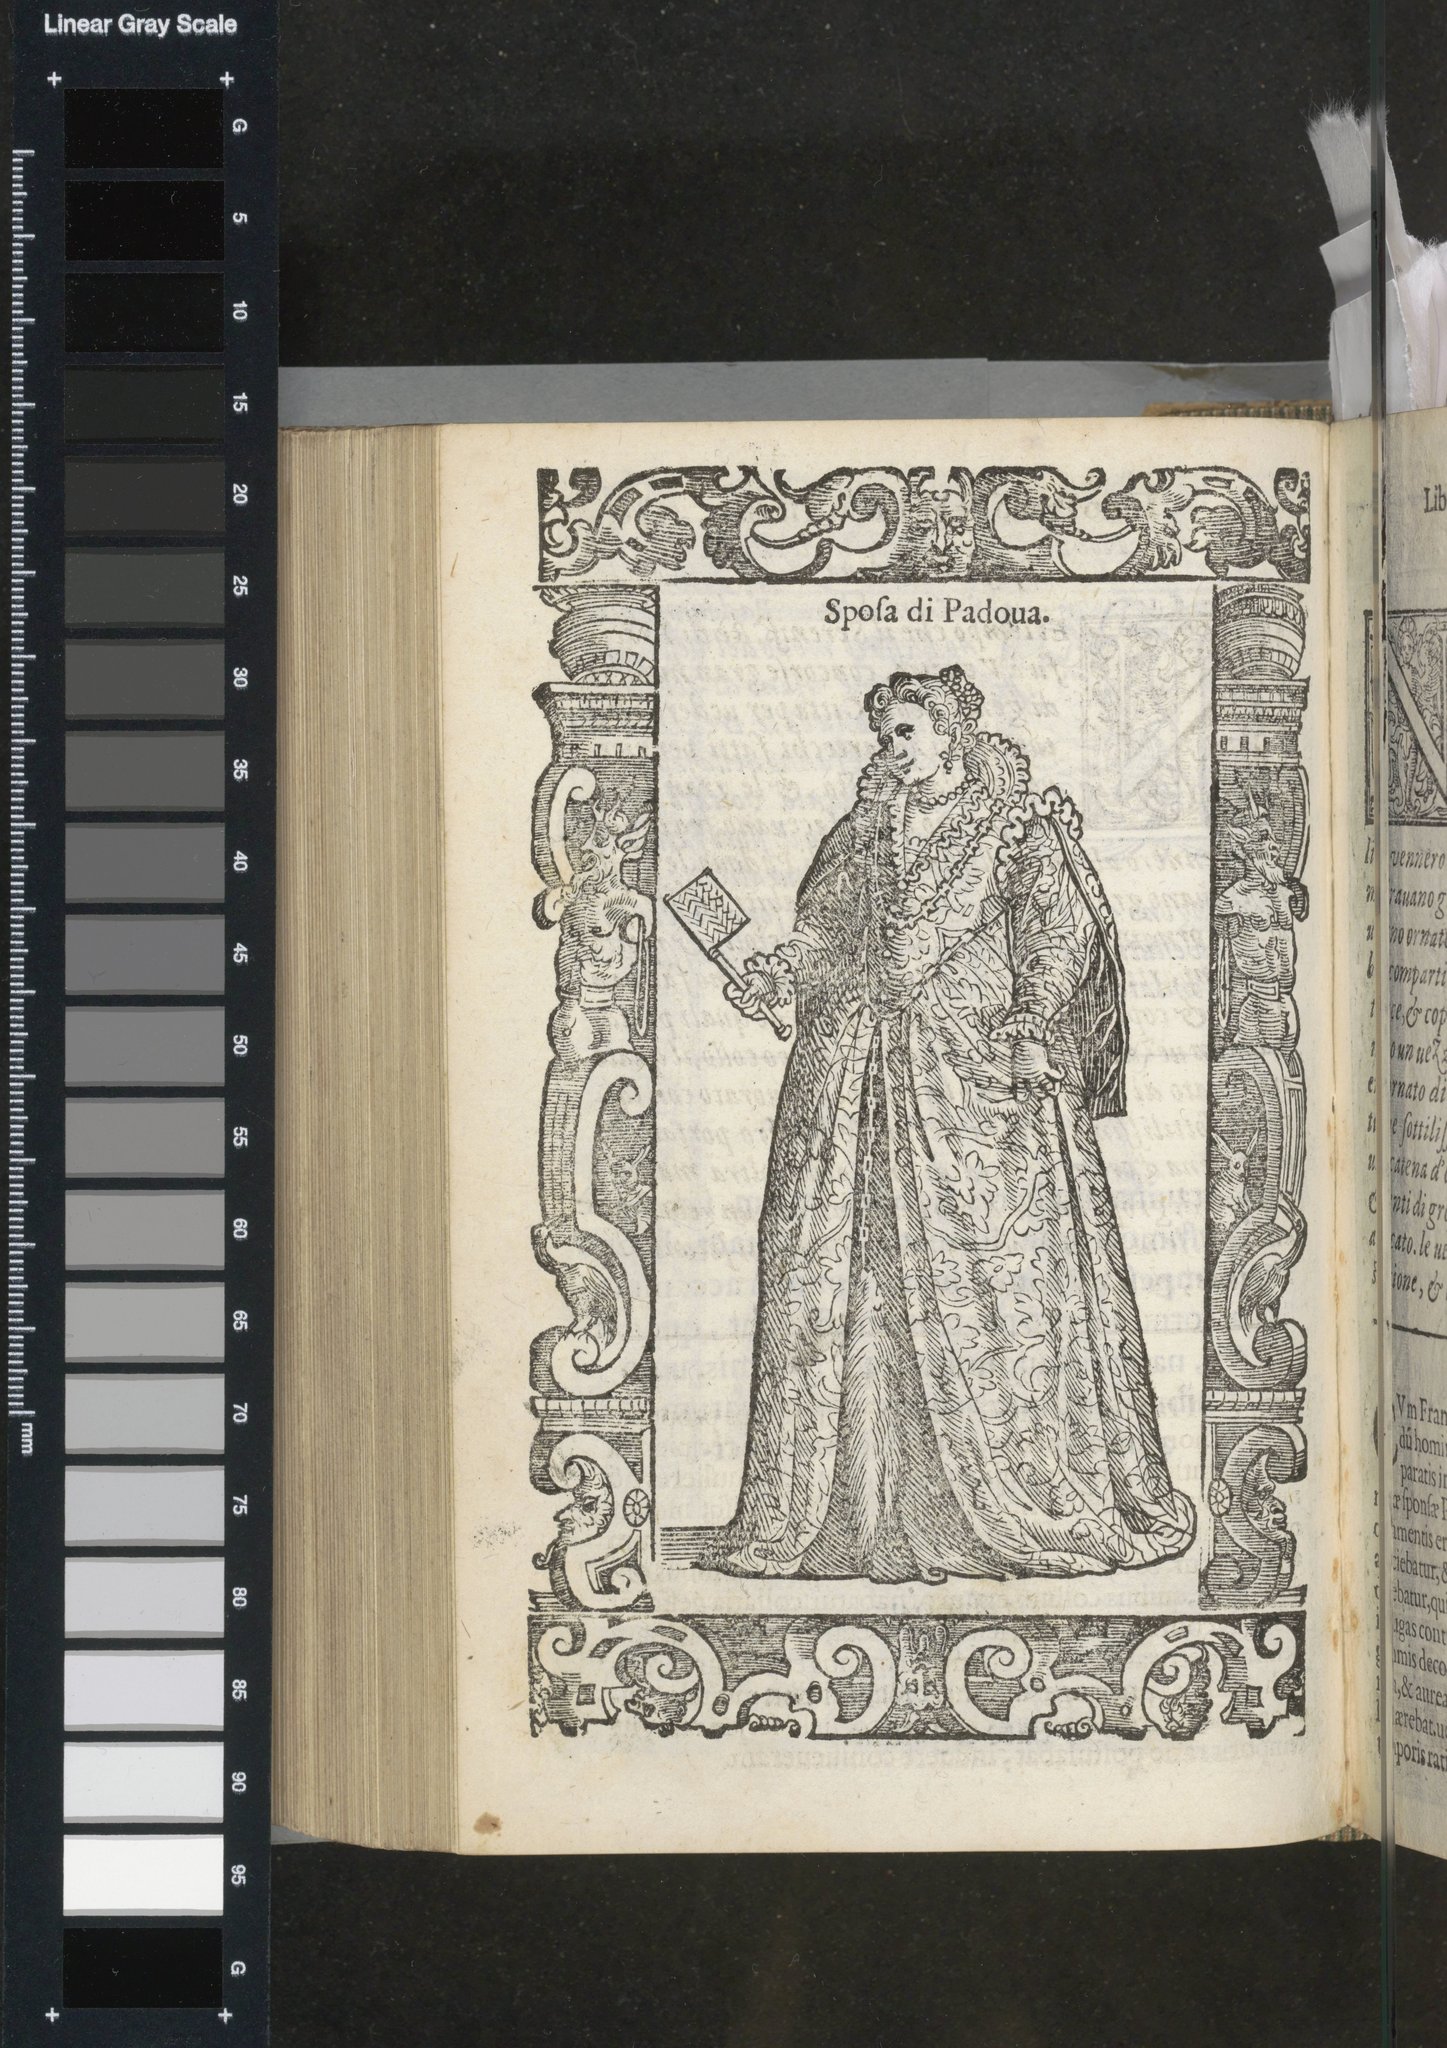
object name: costume print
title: Sposa di padova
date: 1598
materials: paper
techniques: woodcut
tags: fashion plates